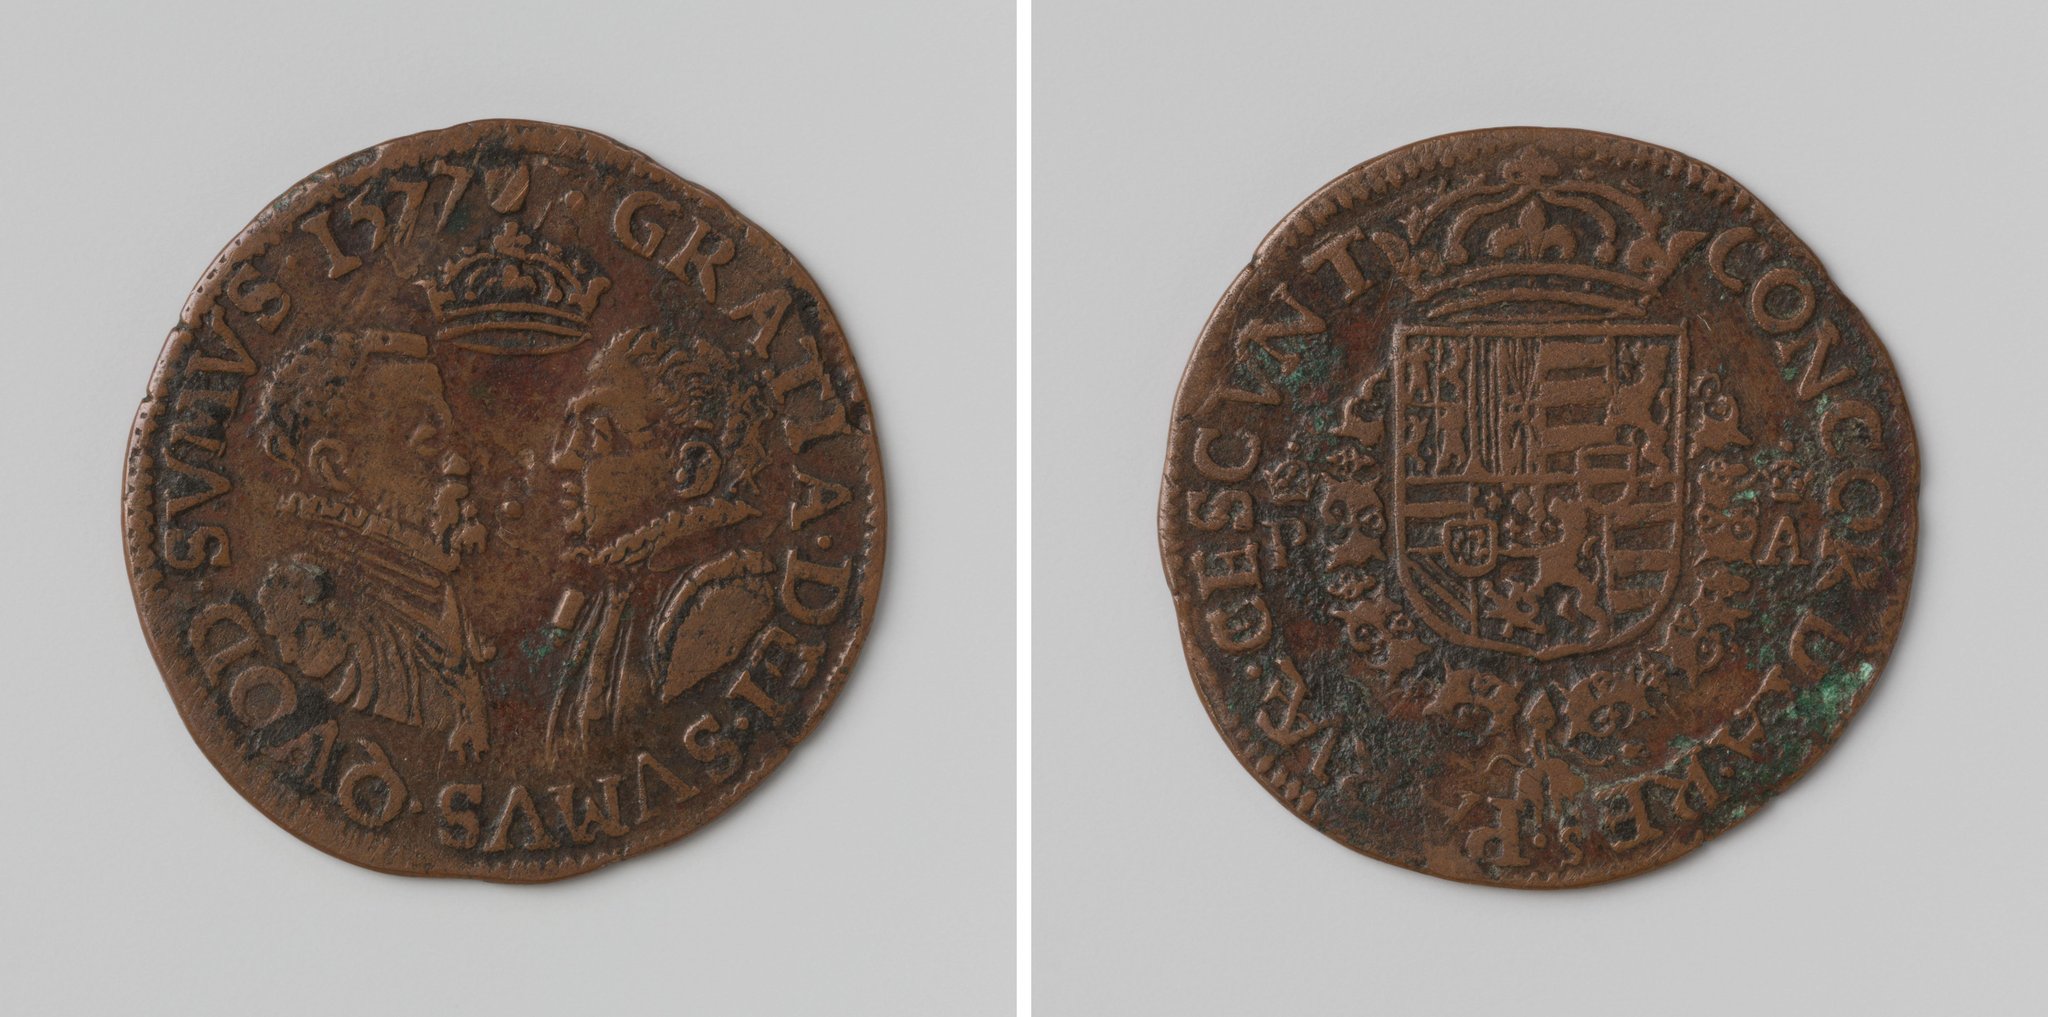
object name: jeton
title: Filips II en Anna-Maria, koning en koningin van Spanje, rekenpenning van de Staten van Utrecht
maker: Anonymous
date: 1577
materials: copper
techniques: striking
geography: utrecht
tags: philip ii of spain, utrecht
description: Koperen penning. Voorzijde: naar elkaar gewende borststukken van man en vrouw onder kroon binnen omschrift. Keerzijde: gekroond wapenschild, omhangen met de orde van het Gulden Vlies, geflankeerd door gekroonde letter P en gekroonde letter A binnen omschrift